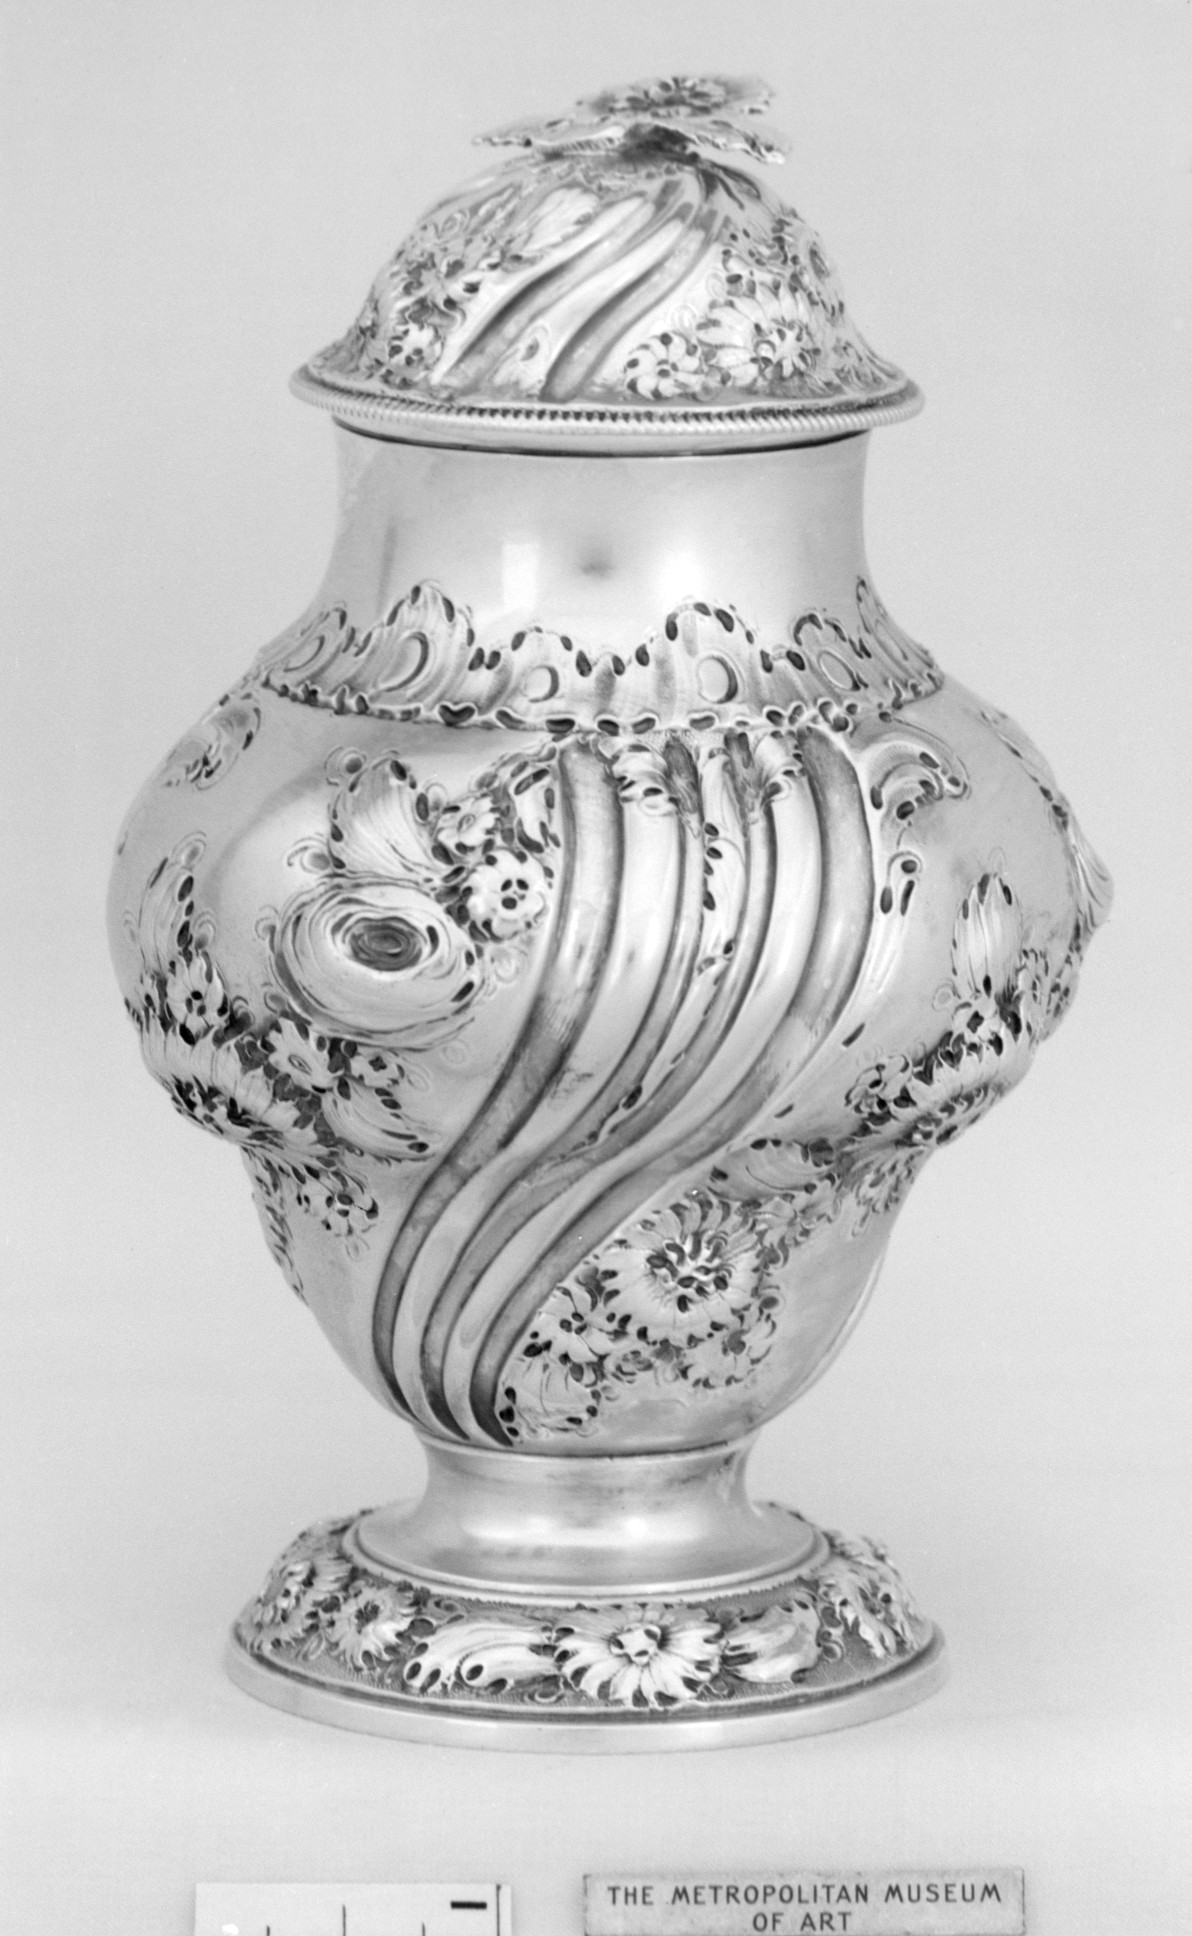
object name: tea caddy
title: Pair of tea caddies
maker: samuel taylor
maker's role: maker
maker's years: 1744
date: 1751-1752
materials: silver